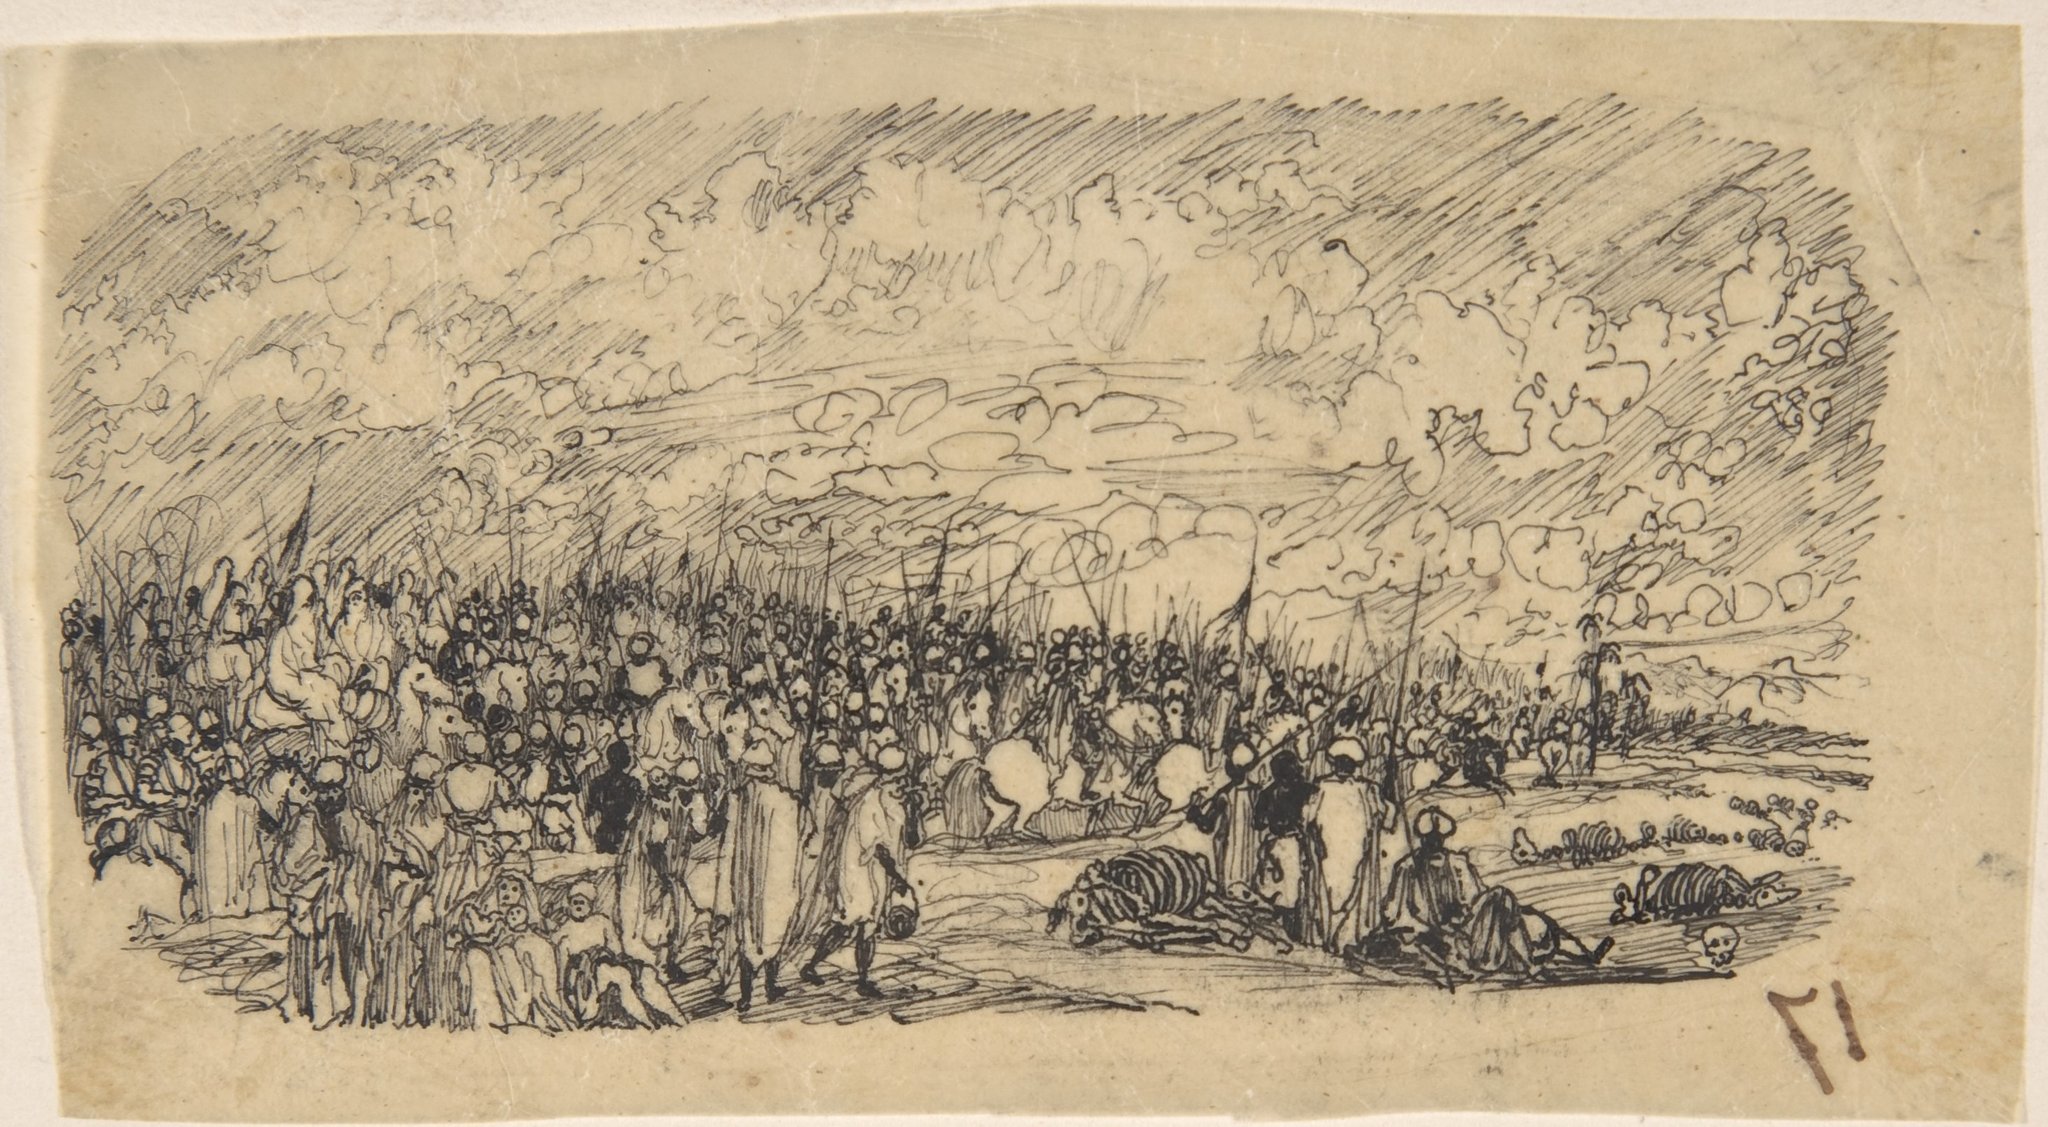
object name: drawing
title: After the Battle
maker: rodolphe bresdin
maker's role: artist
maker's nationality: french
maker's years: 1822-1885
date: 1822-1885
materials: ink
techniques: pen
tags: men,horses